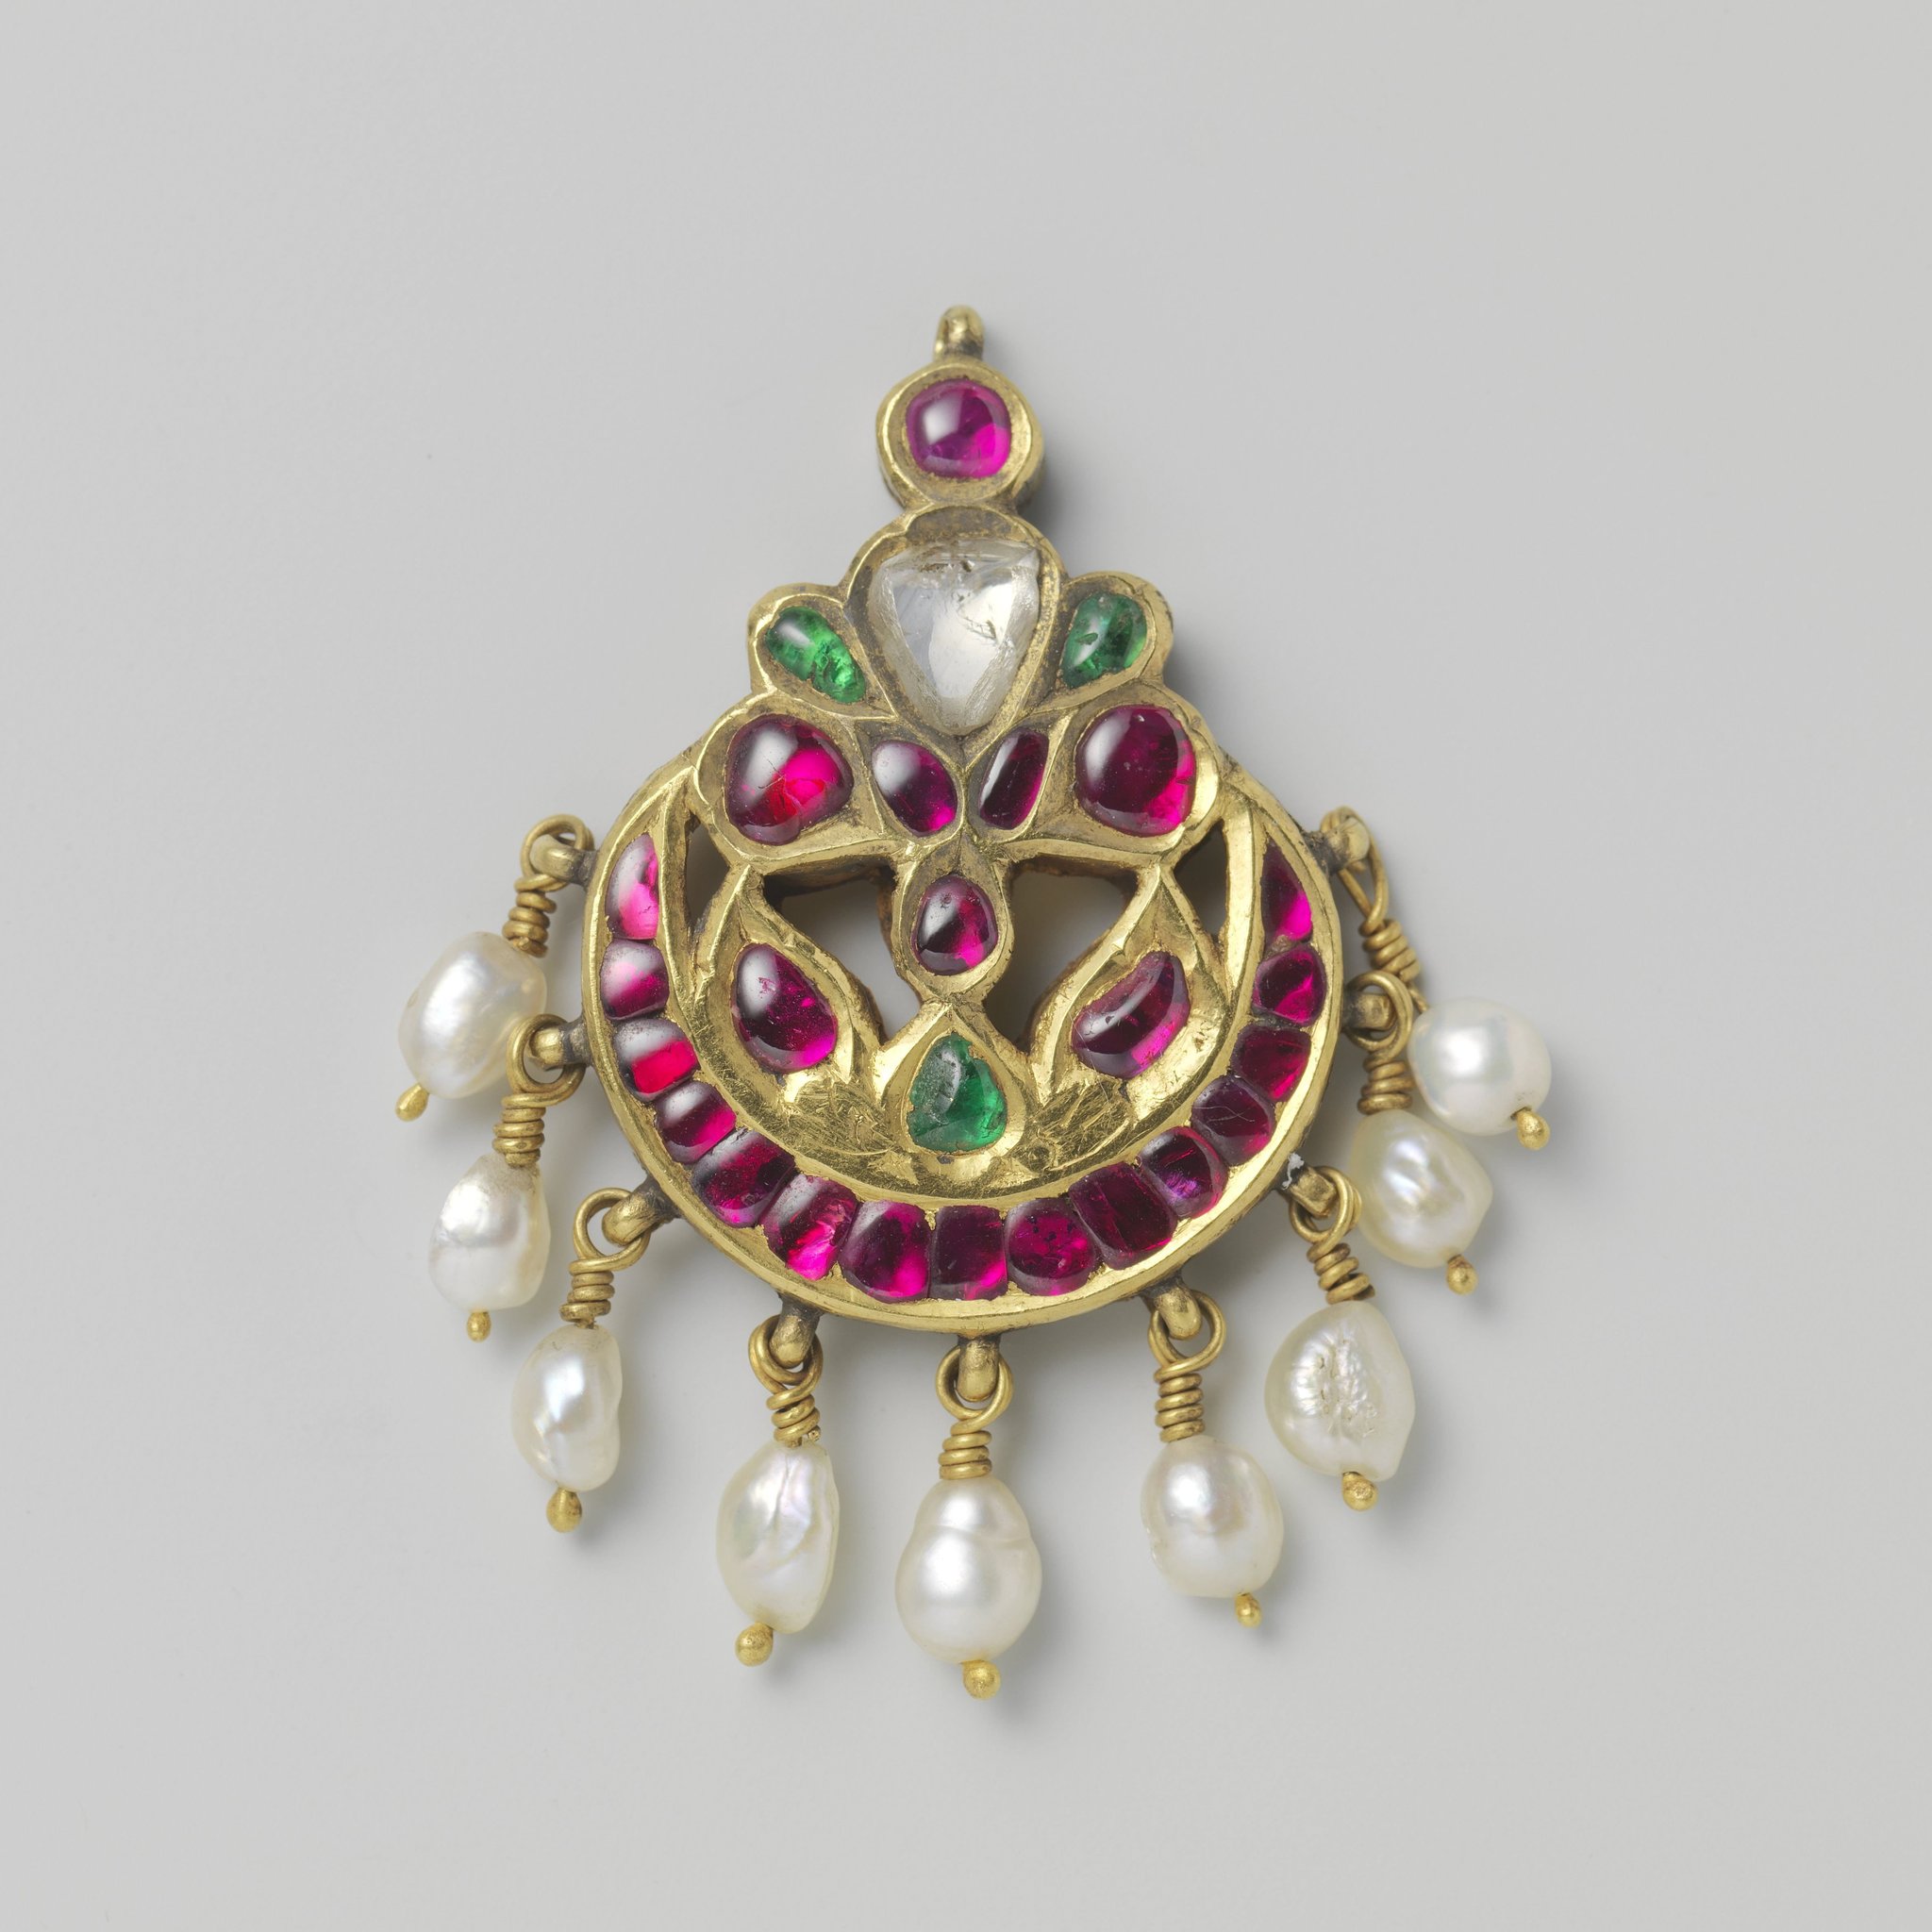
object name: jewellery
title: Pair of Earrings and Two Hair Ornaments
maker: Anonymous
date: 1750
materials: diamond, gold, pearl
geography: surat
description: These jewels are part of an ensemble collected by Julius Stein van Gollenesse, director-general of the VOC (Dutch East India Company) in Batavia (now Jakarta). Attached to the top of the ornament in the shape of a horizontal crescent moon is a tiny eye. A pearl necklace would have been affixed to it, and the jewel then pinned in the hair so that it would fall in the middle of the forehead. The round ornament was worn on the side of the head.